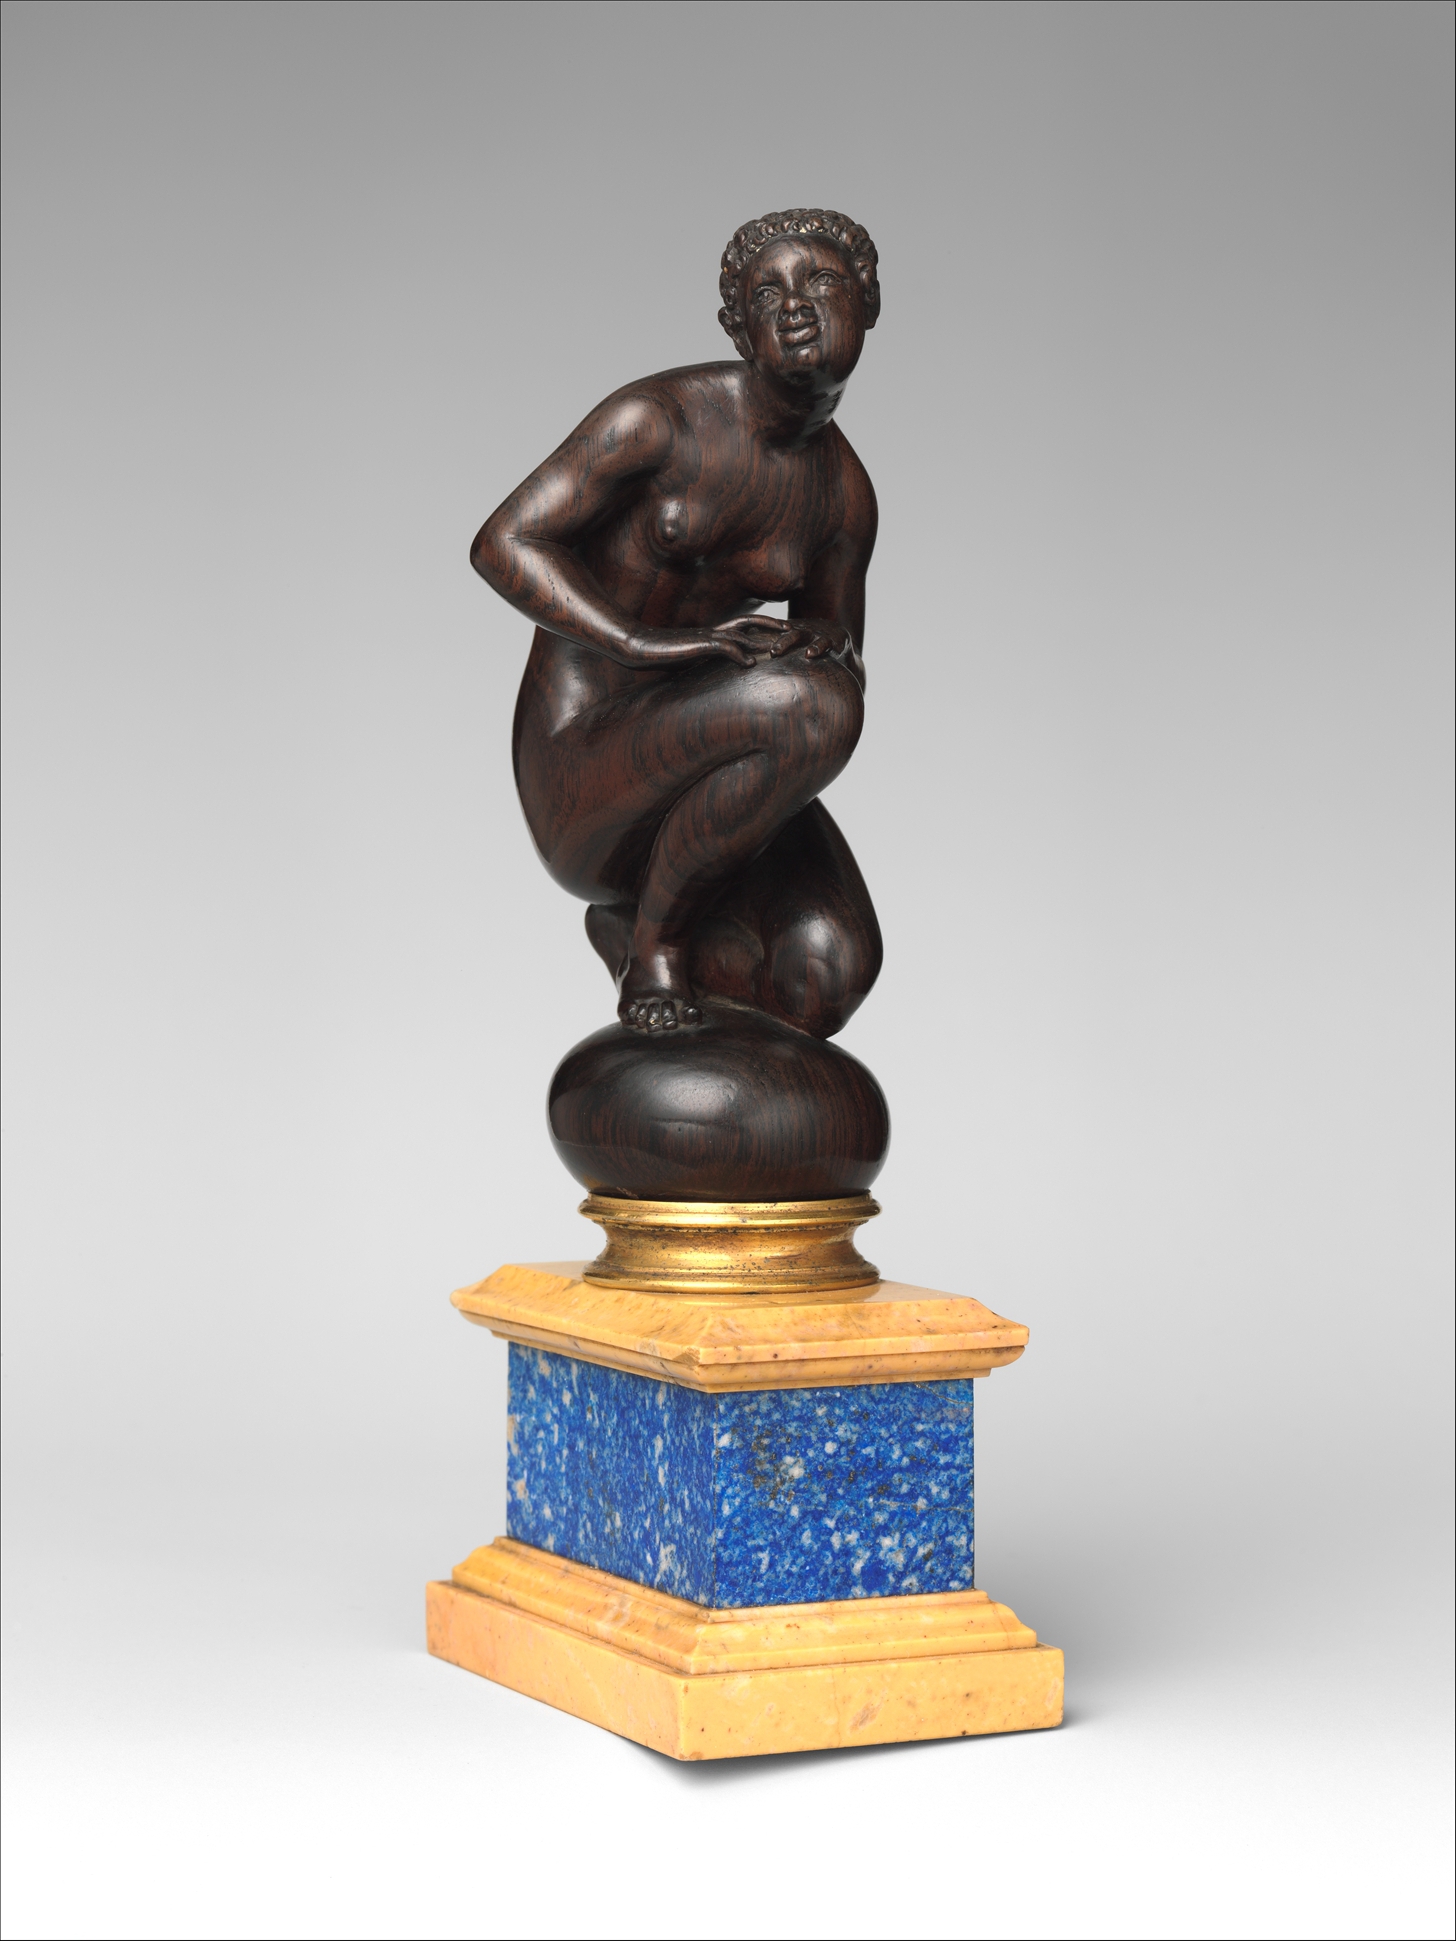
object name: statuette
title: Kneeling Black woman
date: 1601-1633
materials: lapis lazuli, marble, metal, wood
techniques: gilding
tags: female nudes